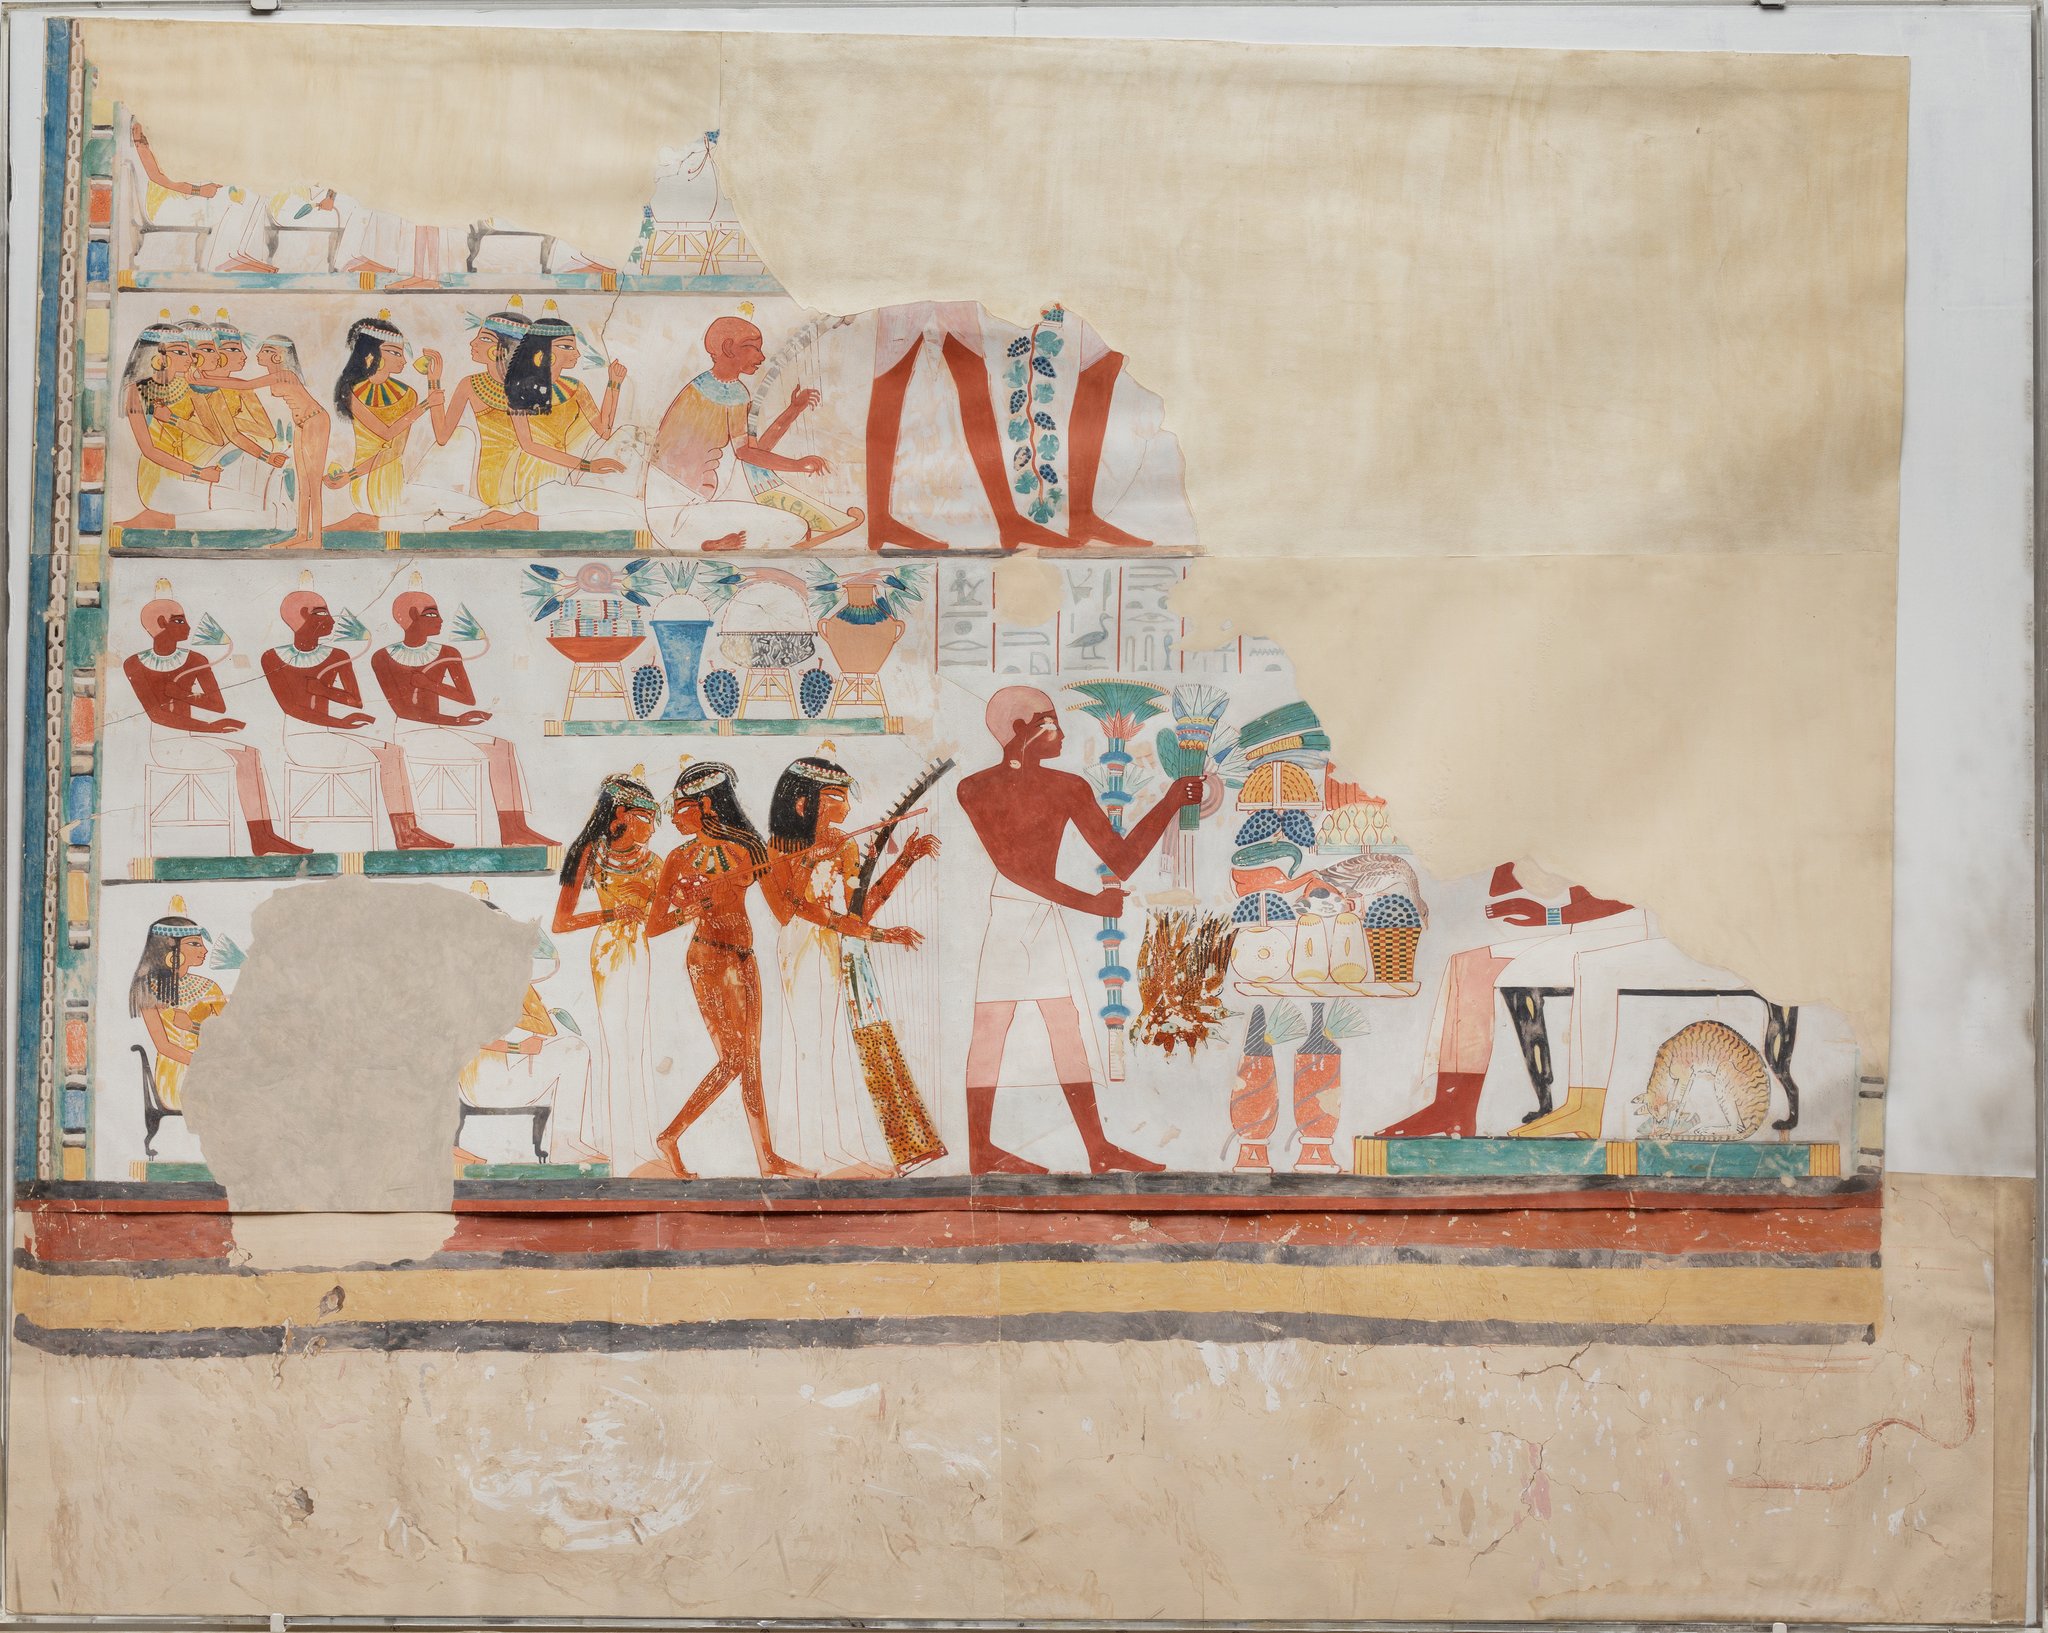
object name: facsimile, nakht tt 52, banquet, musician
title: Banquet Scene with Musicians, Tomb of Nakht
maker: norman de garis davies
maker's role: artist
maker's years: 1865-1941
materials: paper, paint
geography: egypt